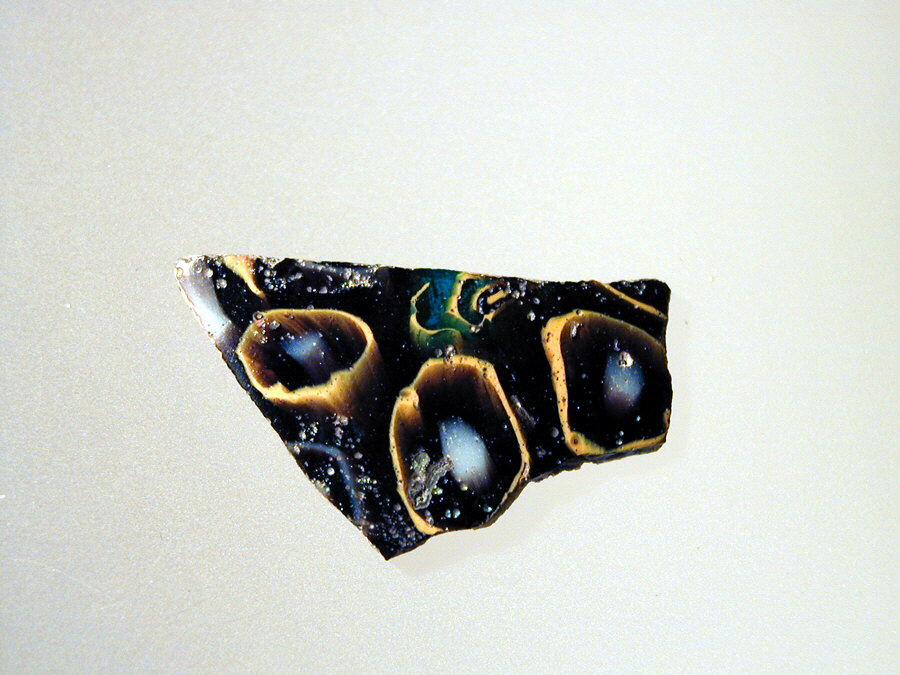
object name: fragment, mosaic bowl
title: Glass mosaic bowl fragment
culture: roman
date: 34 BCE-33 CE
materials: glass